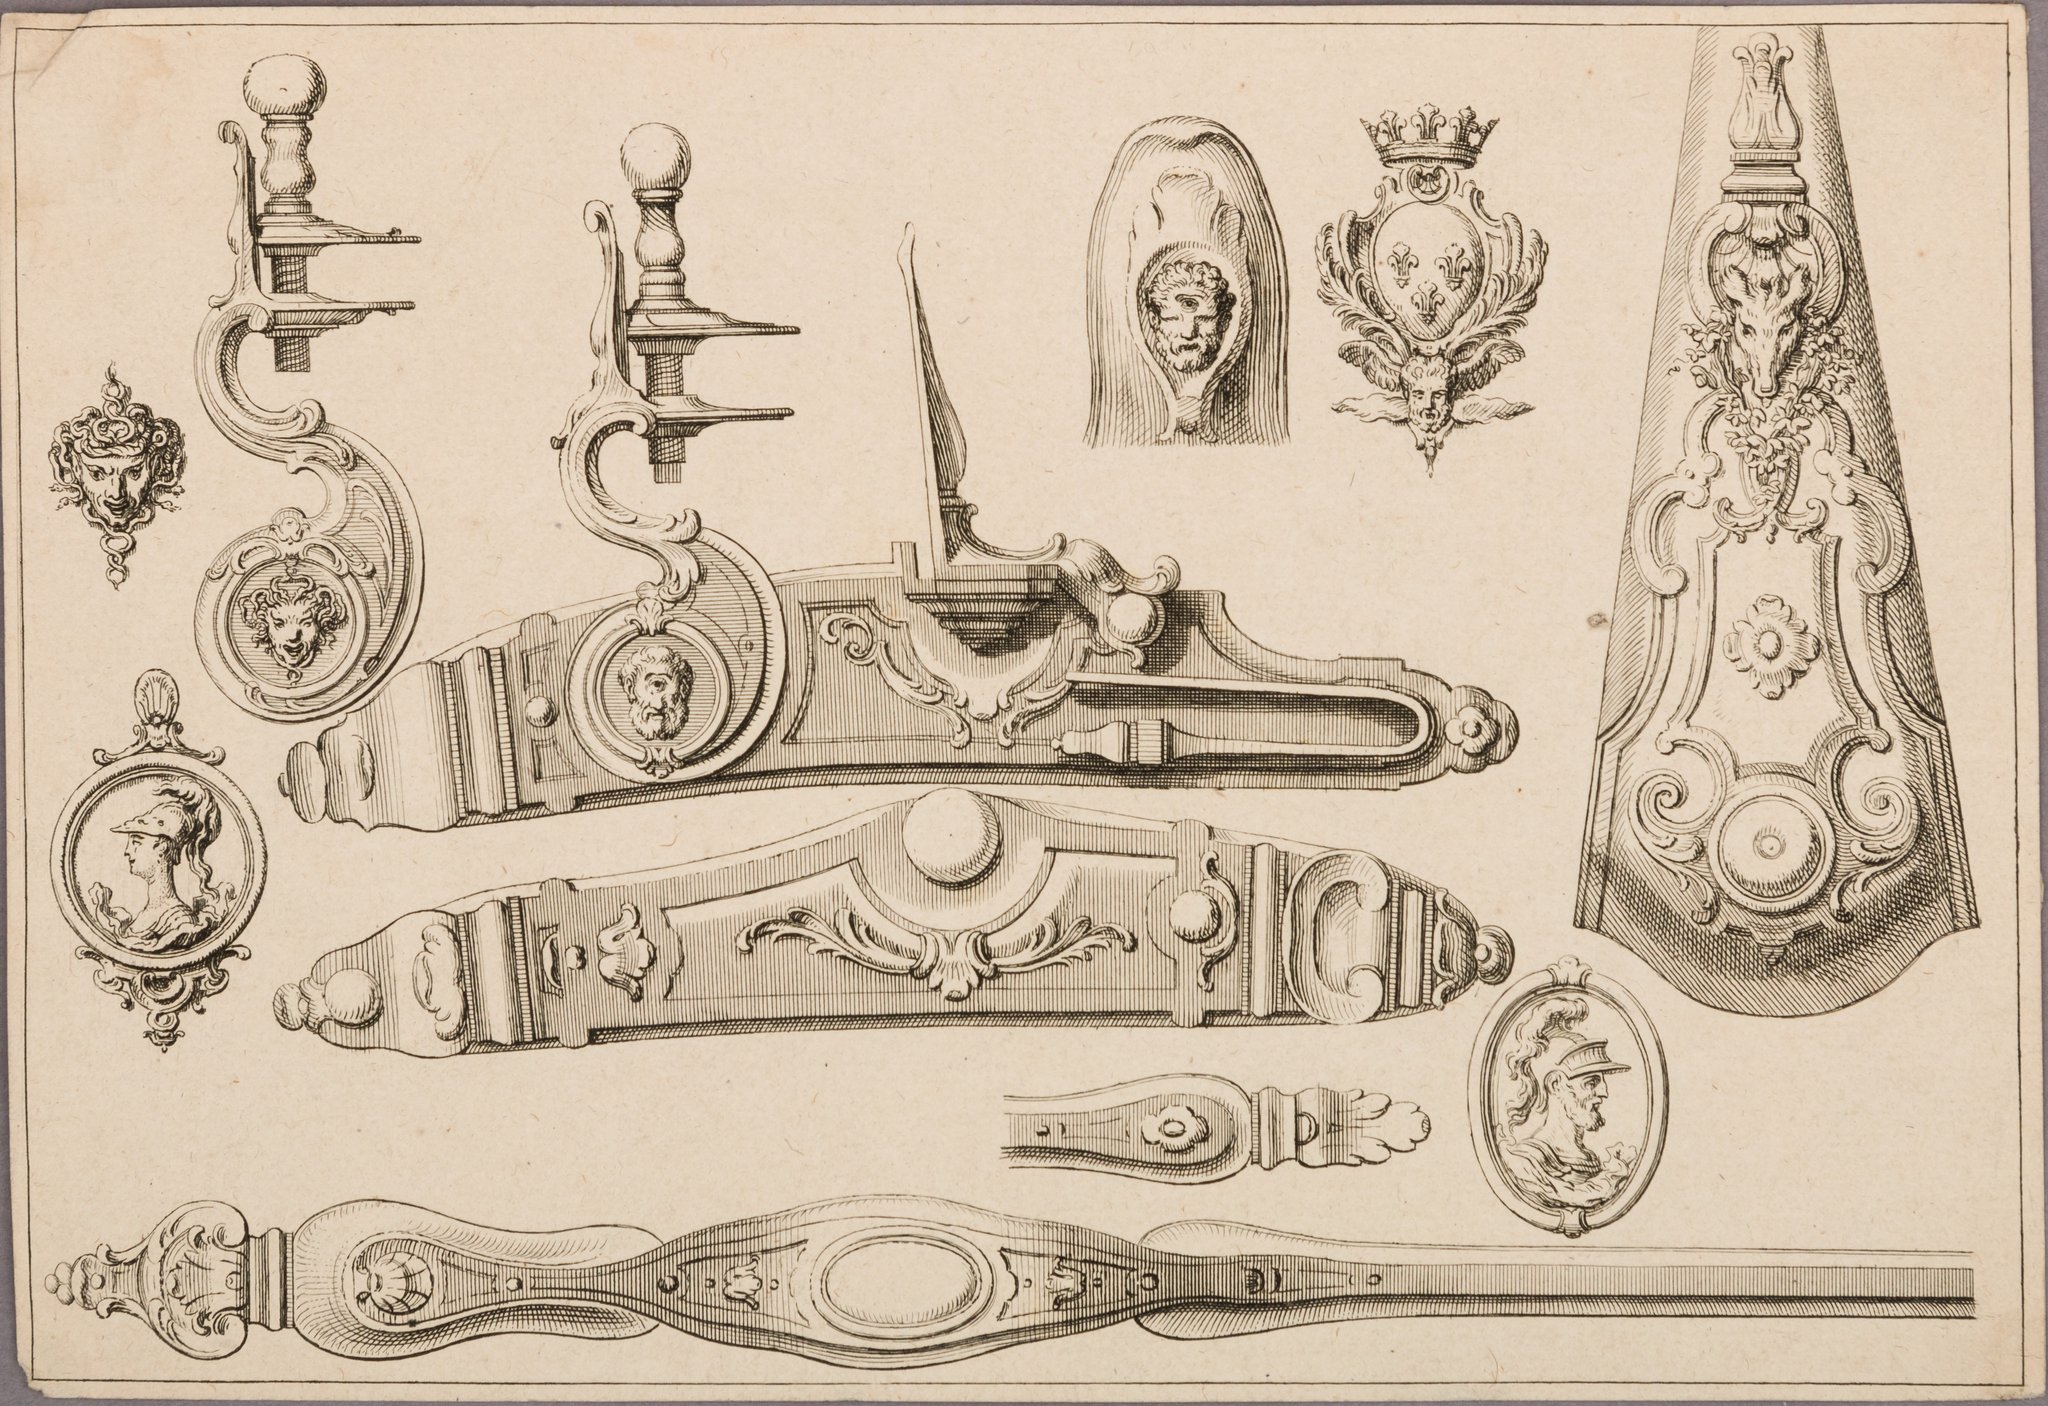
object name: etching and engraving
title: Design of a Flintlock, Side Plate, Butt Plate, and Trigger Guard, unnumbered plate from Nouveaux Desseins d'Arquebuserie Inventez et Gravez par Le Sr. Gillot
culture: french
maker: claude gillot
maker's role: engraver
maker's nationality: french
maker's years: 1673-1722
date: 1715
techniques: engraving, etching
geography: france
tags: ornament